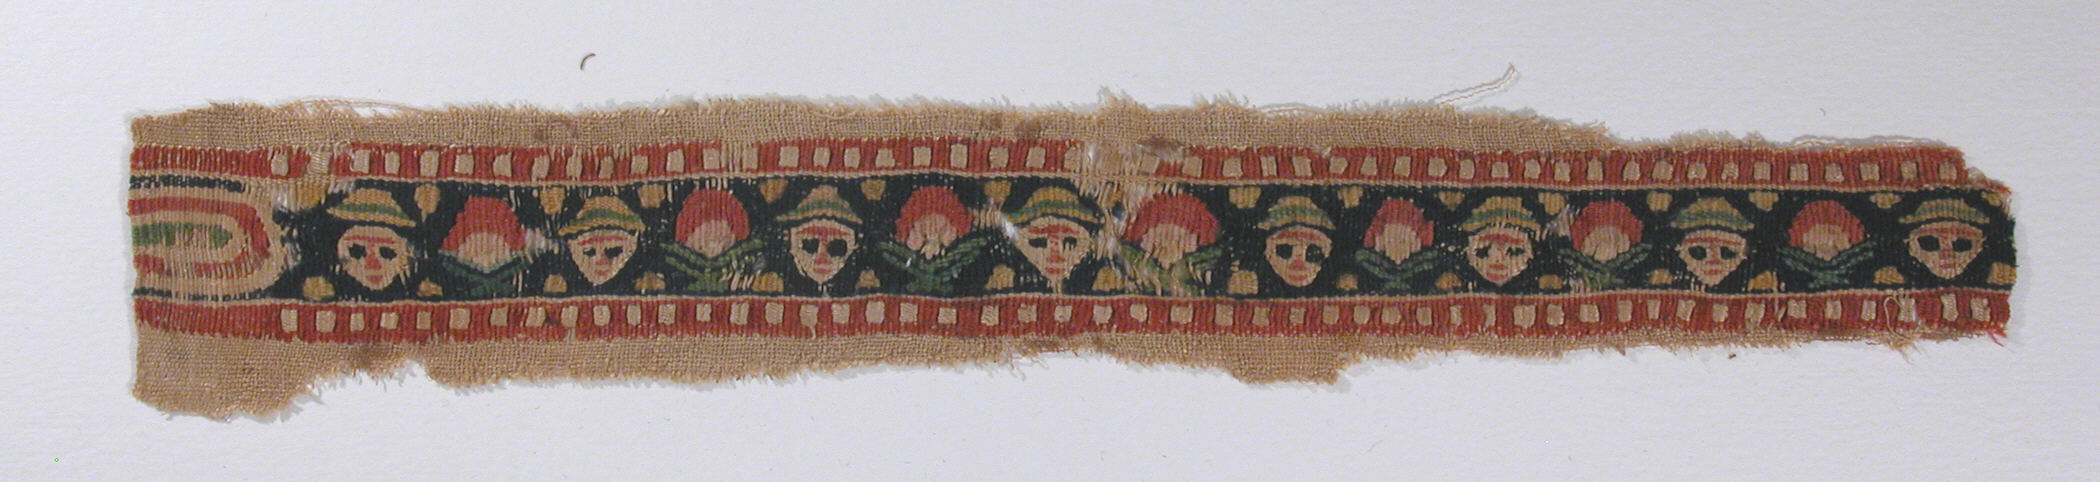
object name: textile fragment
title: Fragment of a Shoulder Band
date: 401-500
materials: linen, wool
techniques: weave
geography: egypt